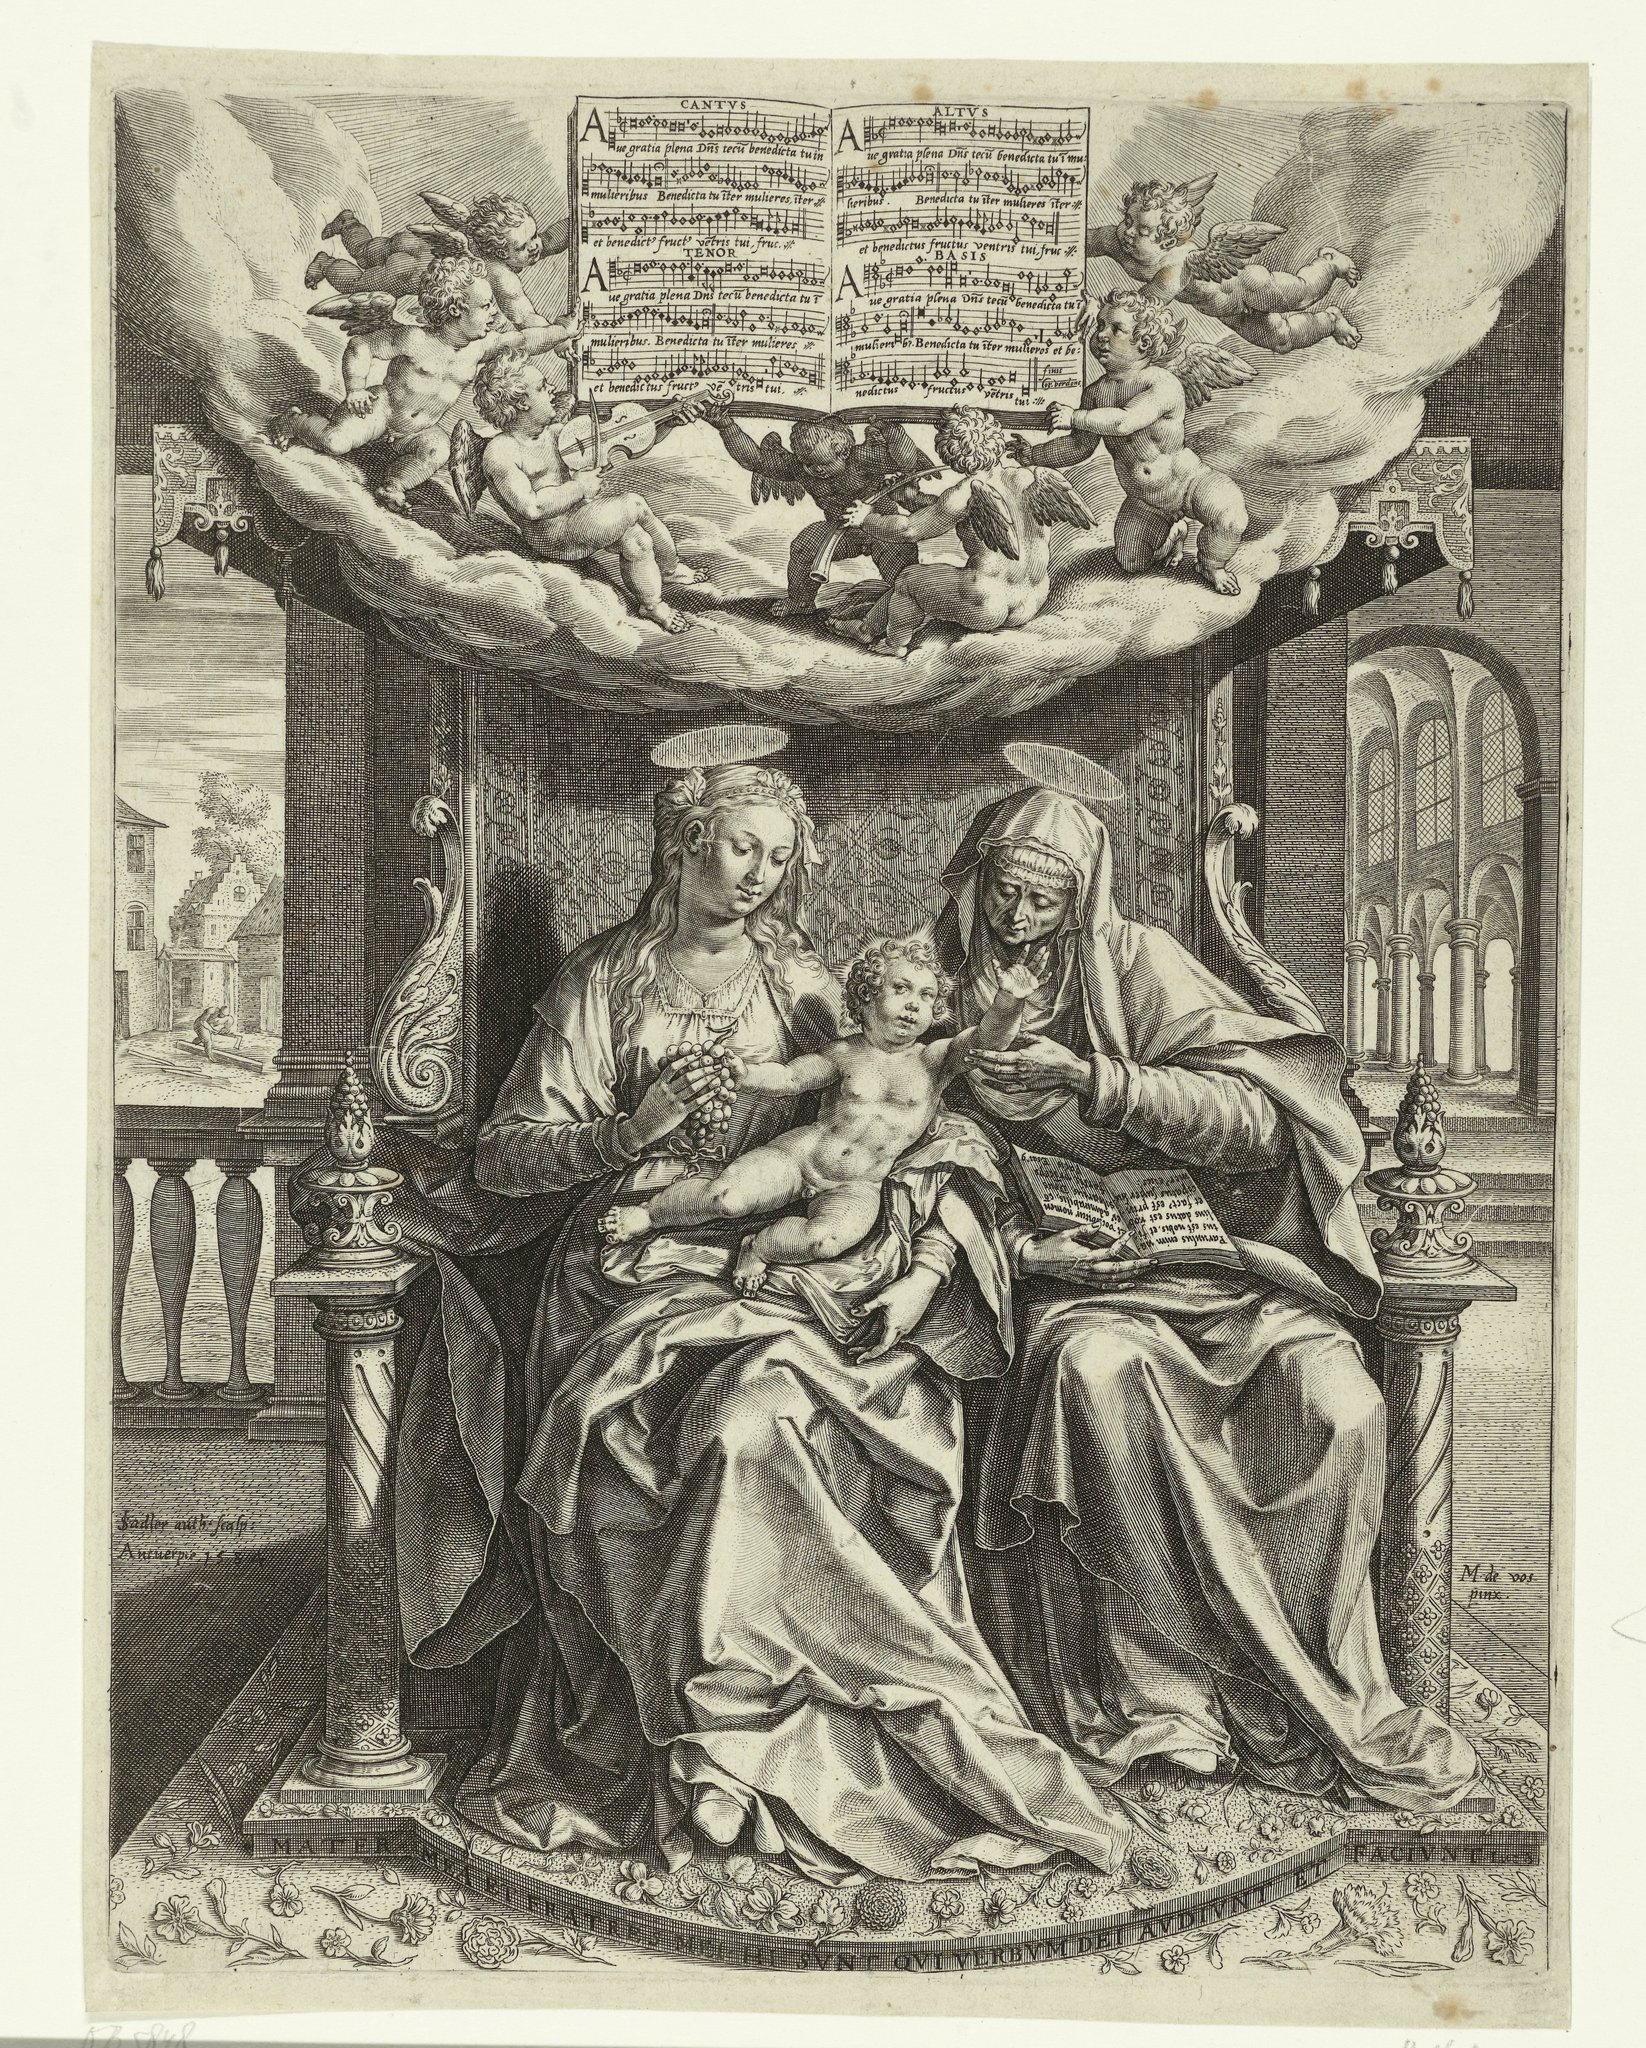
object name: print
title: Anna-te Drieën met het motet 'Ave gratia plena'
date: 1584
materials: paper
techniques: engraving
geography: antwerp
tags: angels singing, making music, printed edition of musical score, still other arrangements of 'anna selbdritt', e.g.: young john the baptist present, isaiah's prophecy of the birth of christ ('immanuel') (possibly with mary, the angel gabriel and king ahaz) (isaiah 7:14-16)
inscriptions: collector's mark: Lugt 240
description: Maria met Kind en de H. Anna, zittend op een troon met baldakijn. Het Kind zit op de schoot van Maria, die een druiventros in haar rechterhand houdt. Op de schoot van de H. Anna een bijbel, openliggend bij de tekst van Jesaja 9.6, waarin de geboorte van Christus wordt aangekondigd. Boven de troon in een wolk vijf engeltjes die een open muziekboek vasthouden waarin muzieknotatie van het vierstemmige motet 'Ave gratia plena' van Cornelis Verdonck. Twee engeltjes die de zink en de viola da braccio bespelen. Op de rand van de troon citaat uit Lukas 1: MATER MEA ET FRATRES MEI HI SUNT, QUI VERBUM DEI AUDIUNT ET FACIUNT.